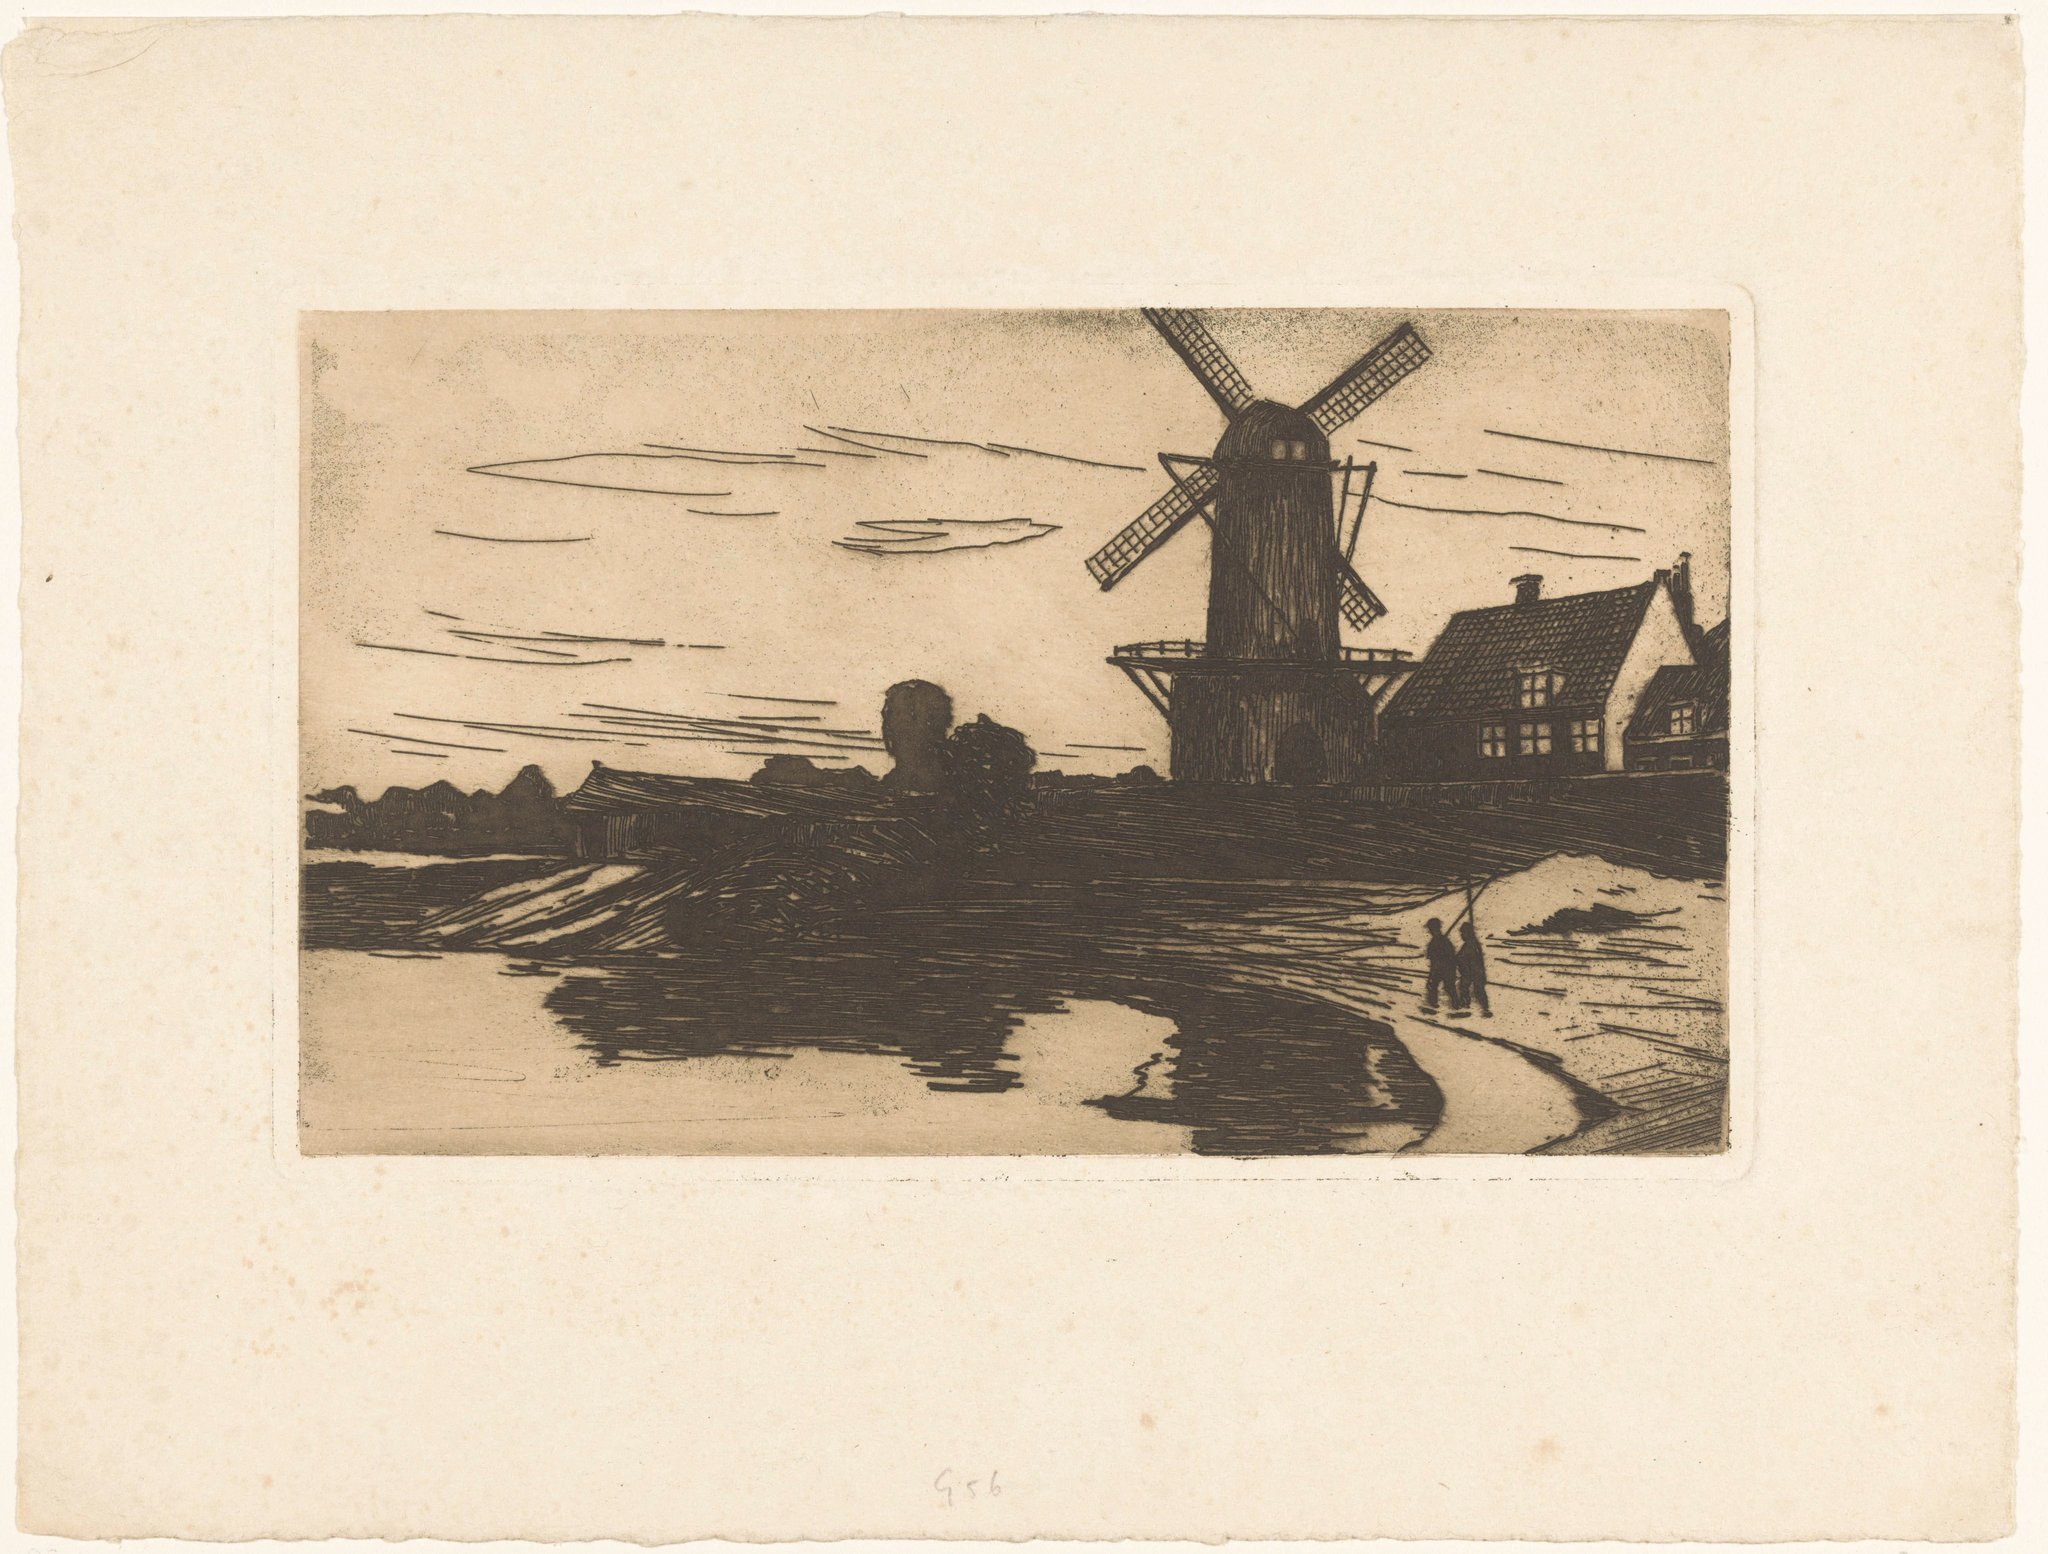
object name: print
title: Molen aan het water bij Wijk bij Duurstede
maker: willem witsen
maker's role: draughtsman, painter, print maker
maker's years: 1860-1923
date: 1906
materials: paper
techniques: etching, intaglio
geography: wijk bij duurstede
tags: river, housing, windmill in landscape, wijk bij duurstede